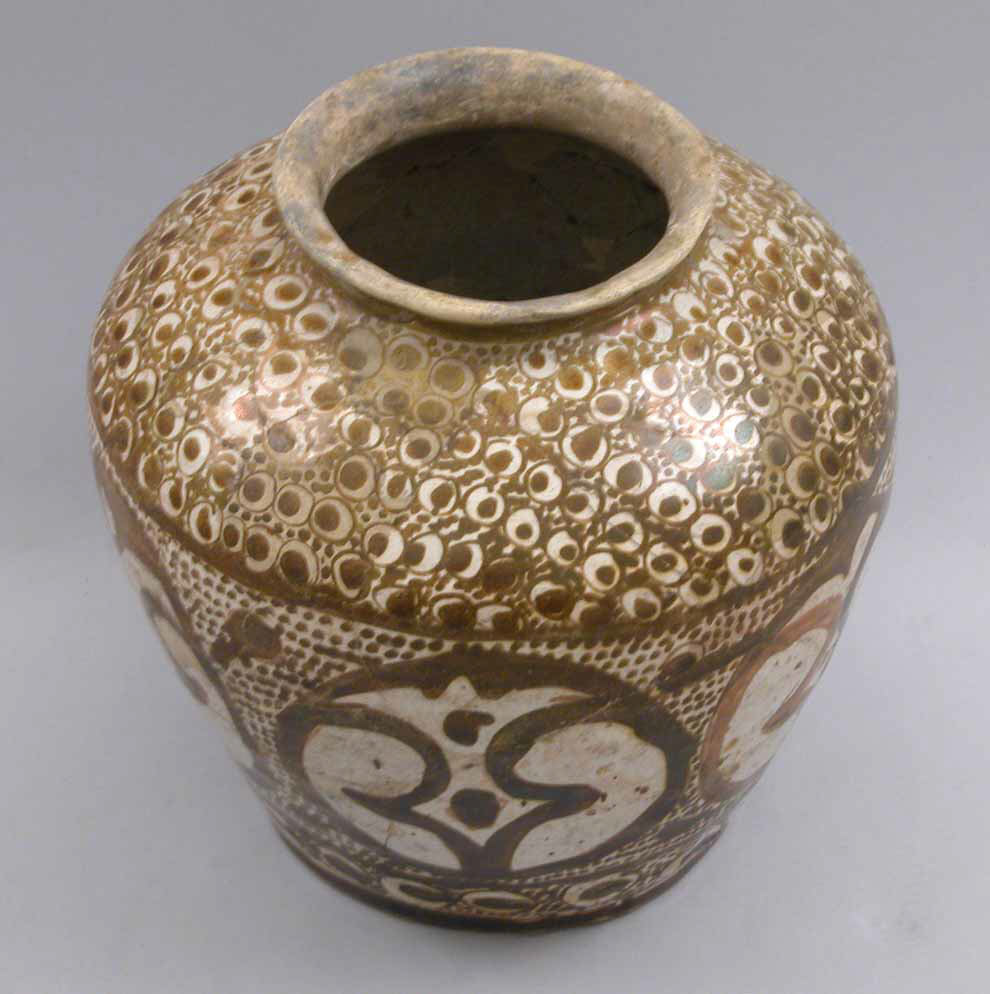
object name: jar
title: Luster Jar with Medallions and Peacock-Eye Pattern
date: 901-1000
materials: earthenware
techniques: luster painting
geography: iraq